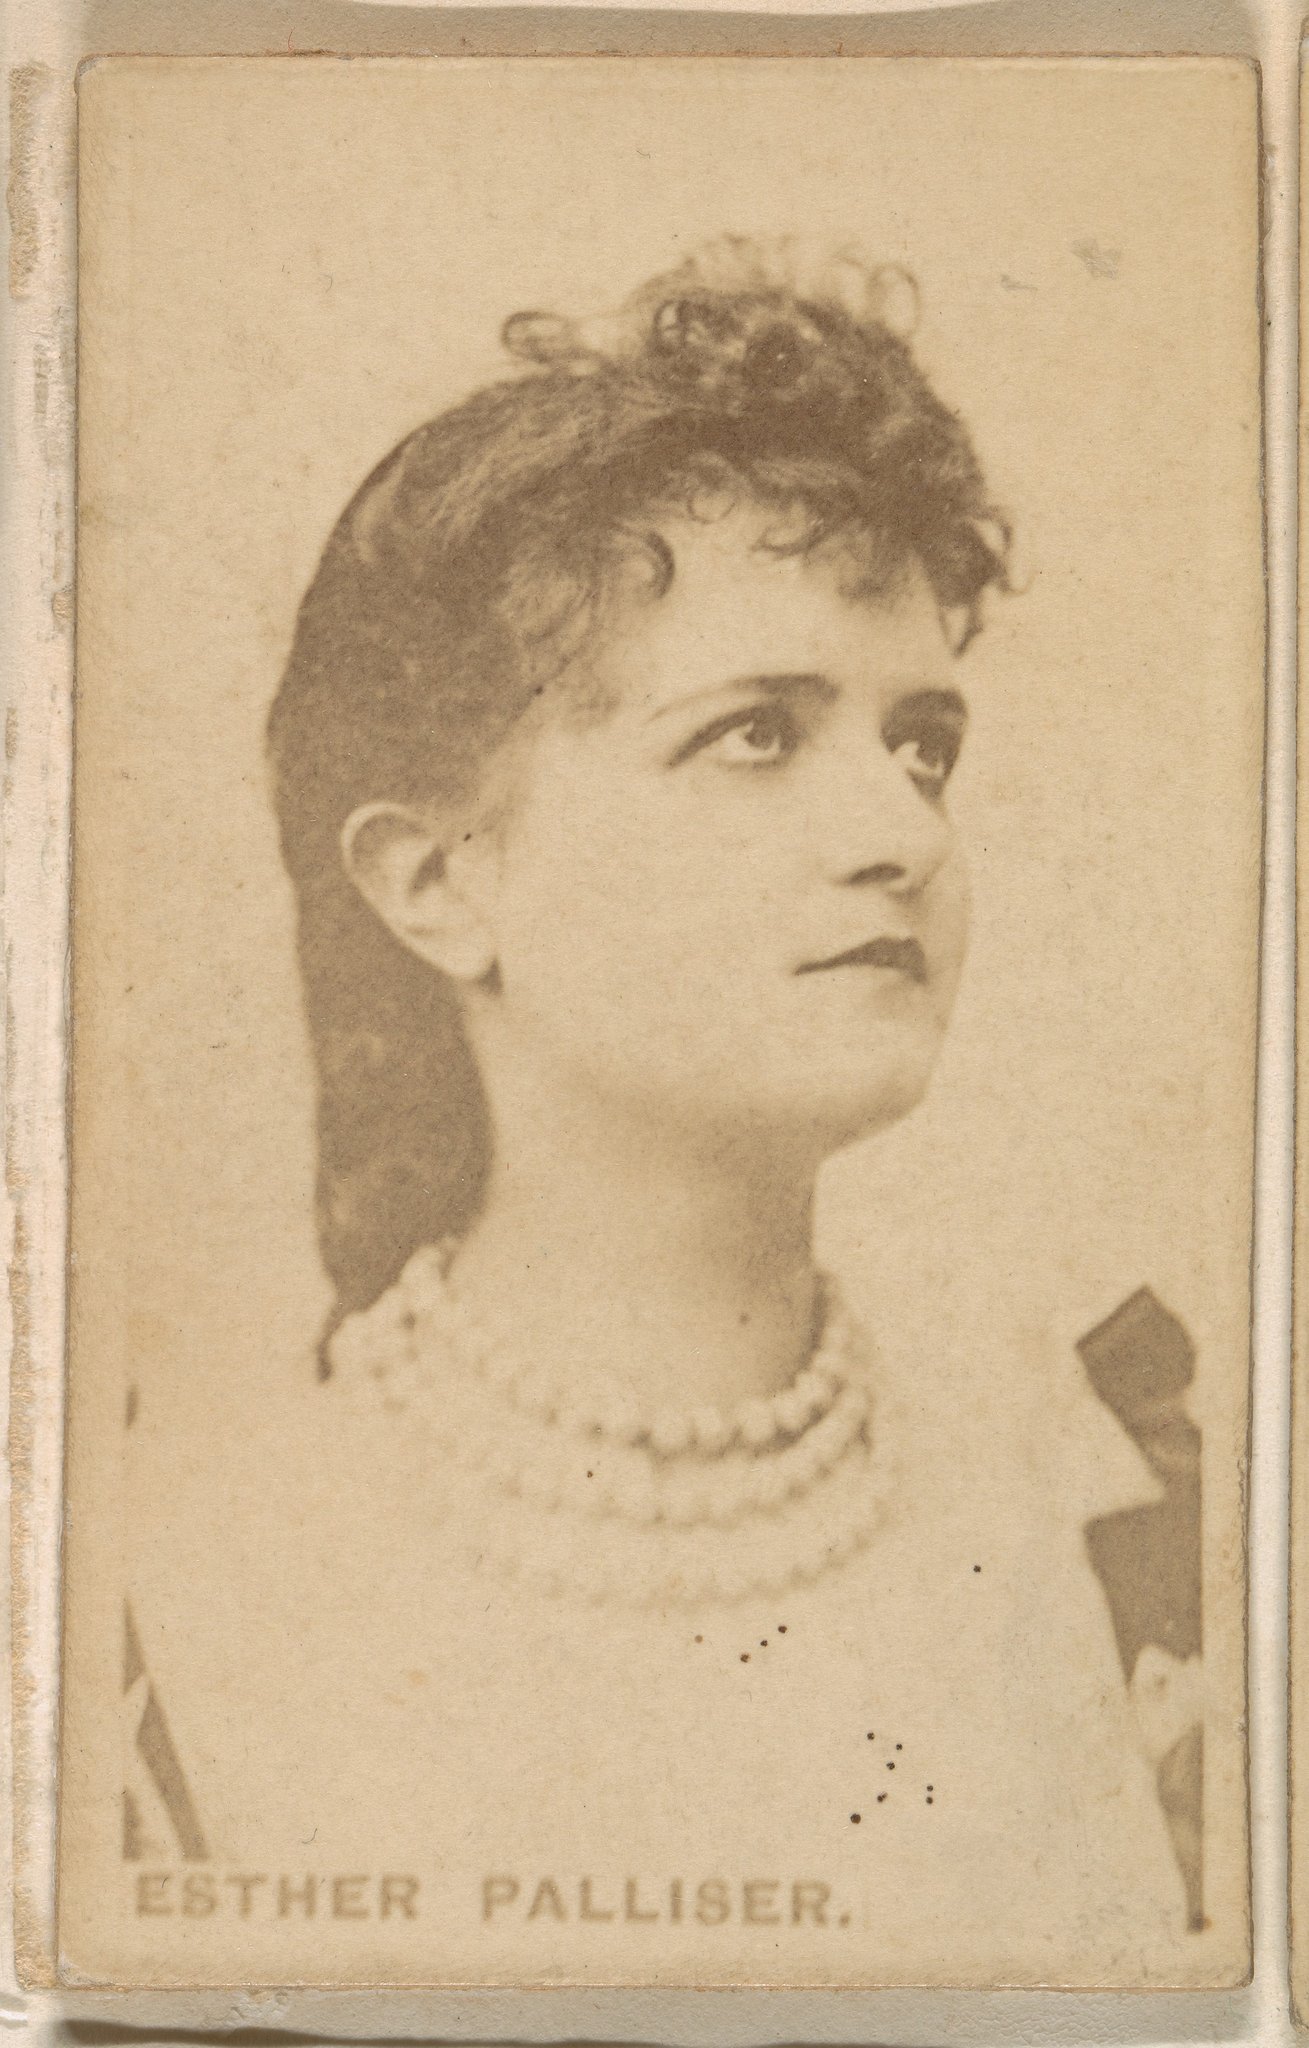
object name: photograph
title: Esther Palliser, from the Actresses series (N246), Type 1, issued by Kinney Brothers to promote Sporting Extra Cigarettes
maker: kinney brothers tobacco company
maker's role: publisher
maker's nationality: american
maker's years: 1869-2011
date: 1890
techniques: albumen silver print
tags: portraits,women,actresses